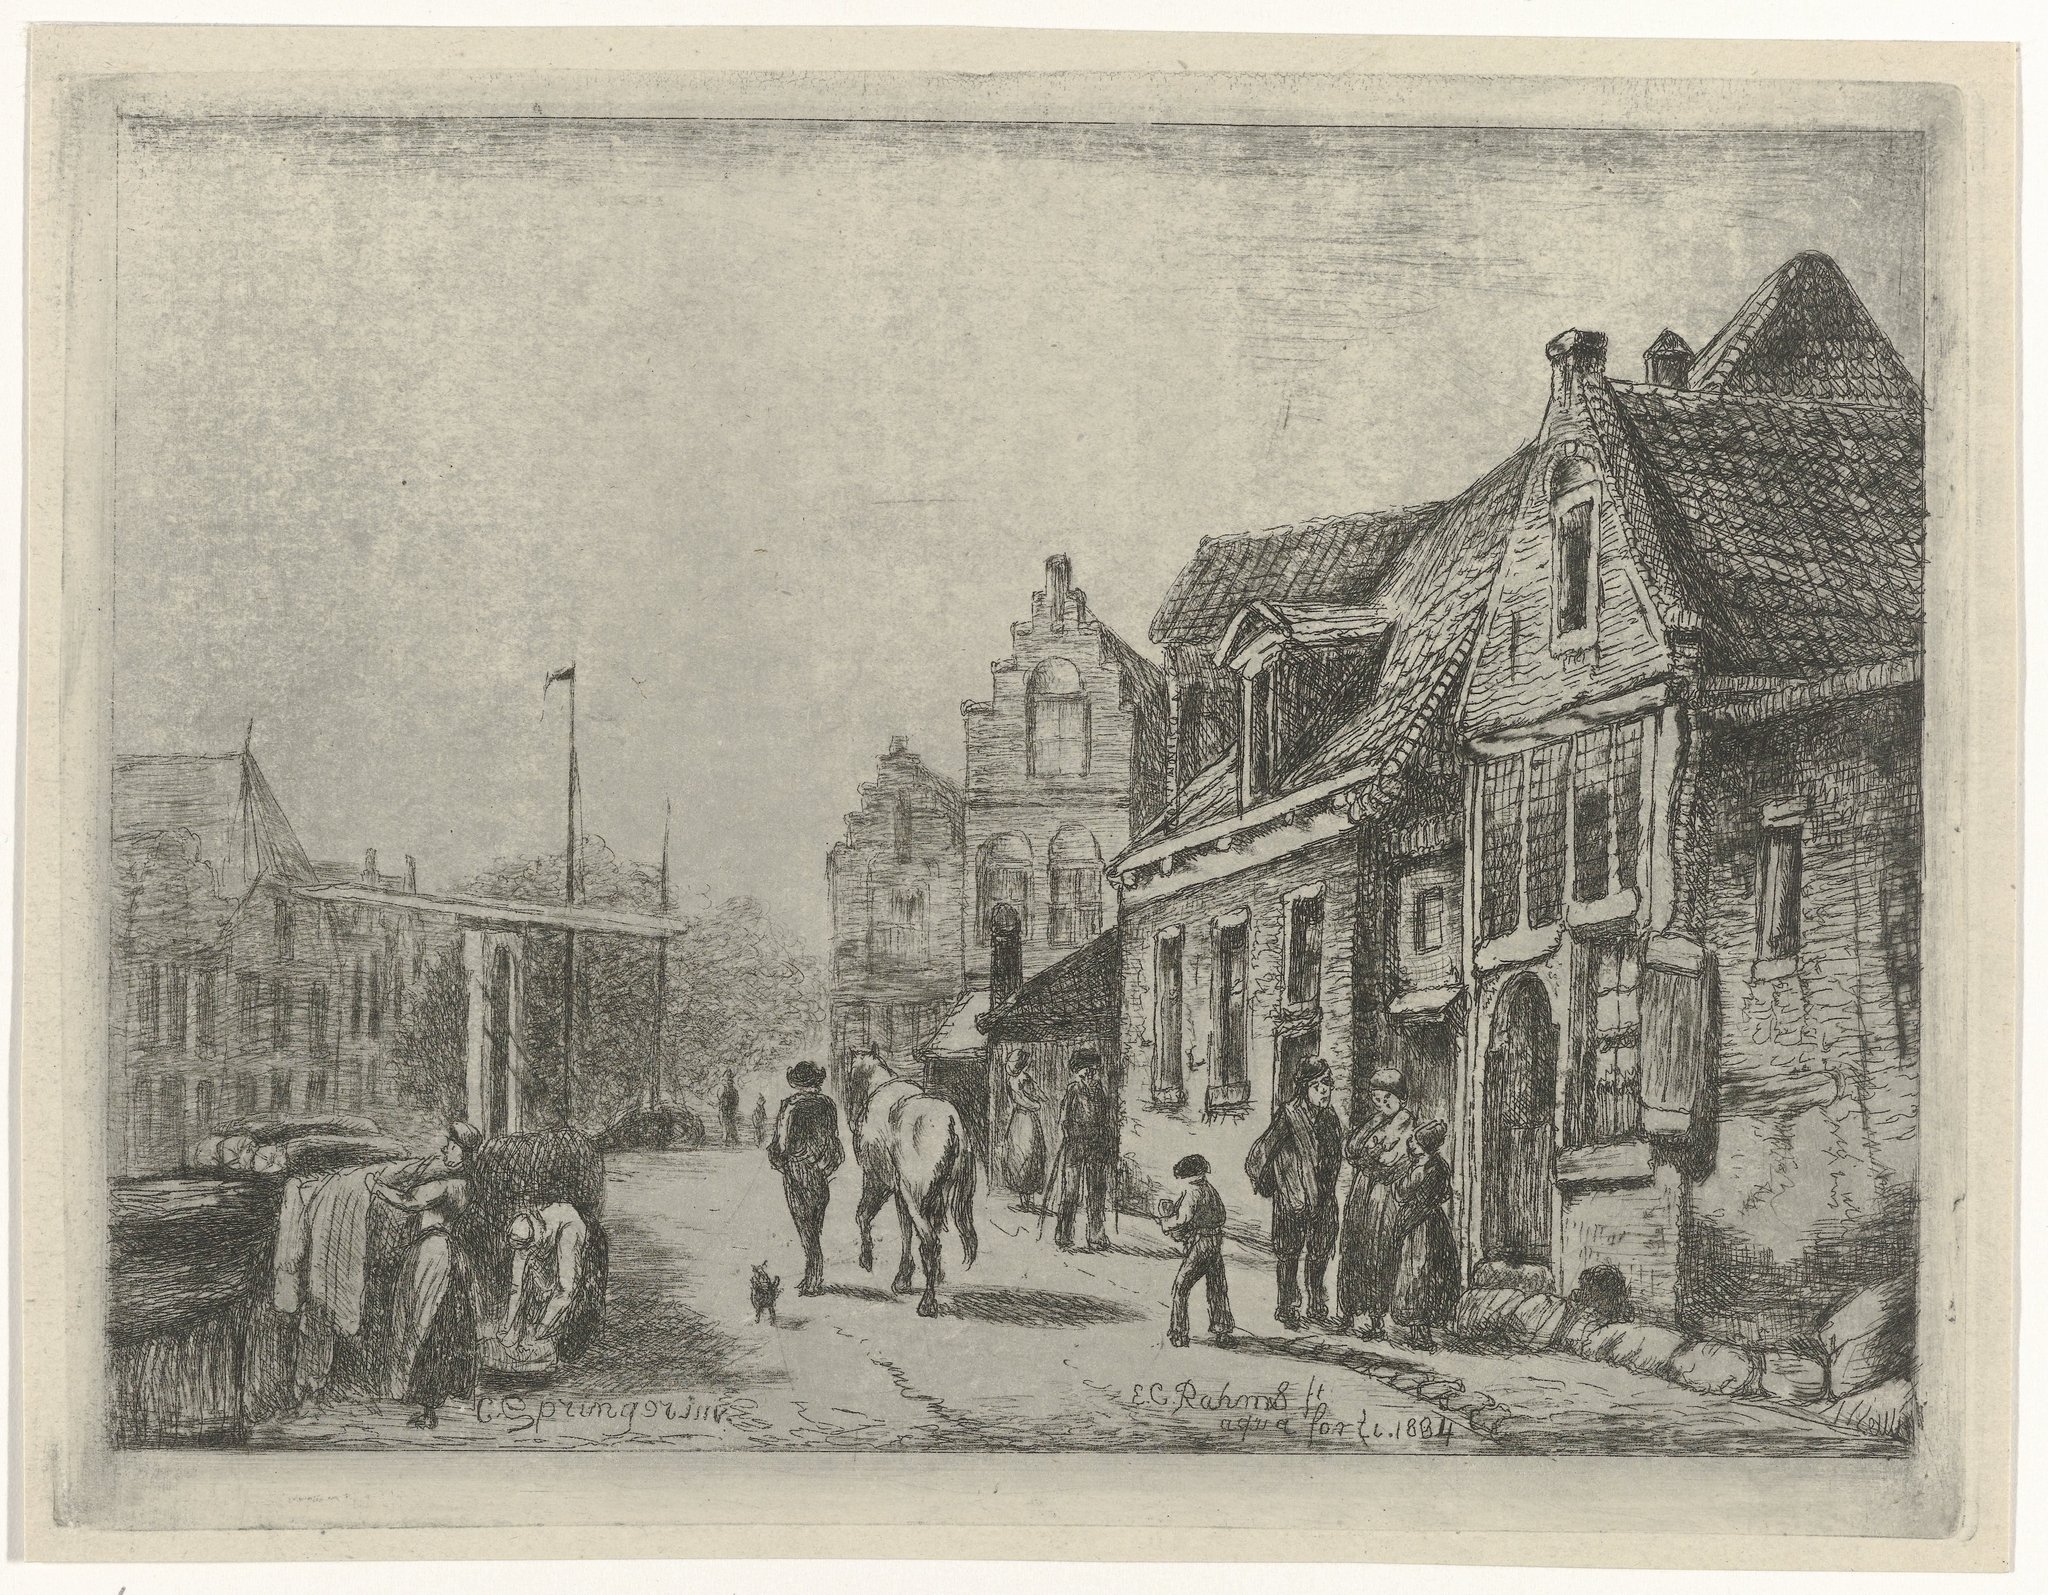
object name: print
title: Stadsgezicht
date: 1884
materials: paper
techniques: etching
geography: oudewater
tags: city-view in general; 'veduta', laundering, horse, street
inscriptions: collector's mark: Lugt 2228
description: Gezicht op een straat in een stad met links vrouwen die de was te drogen hangen. Op straat enkele figuren en een man met een paard. Op de achtergrond een ophaalbrug en masten van boten.